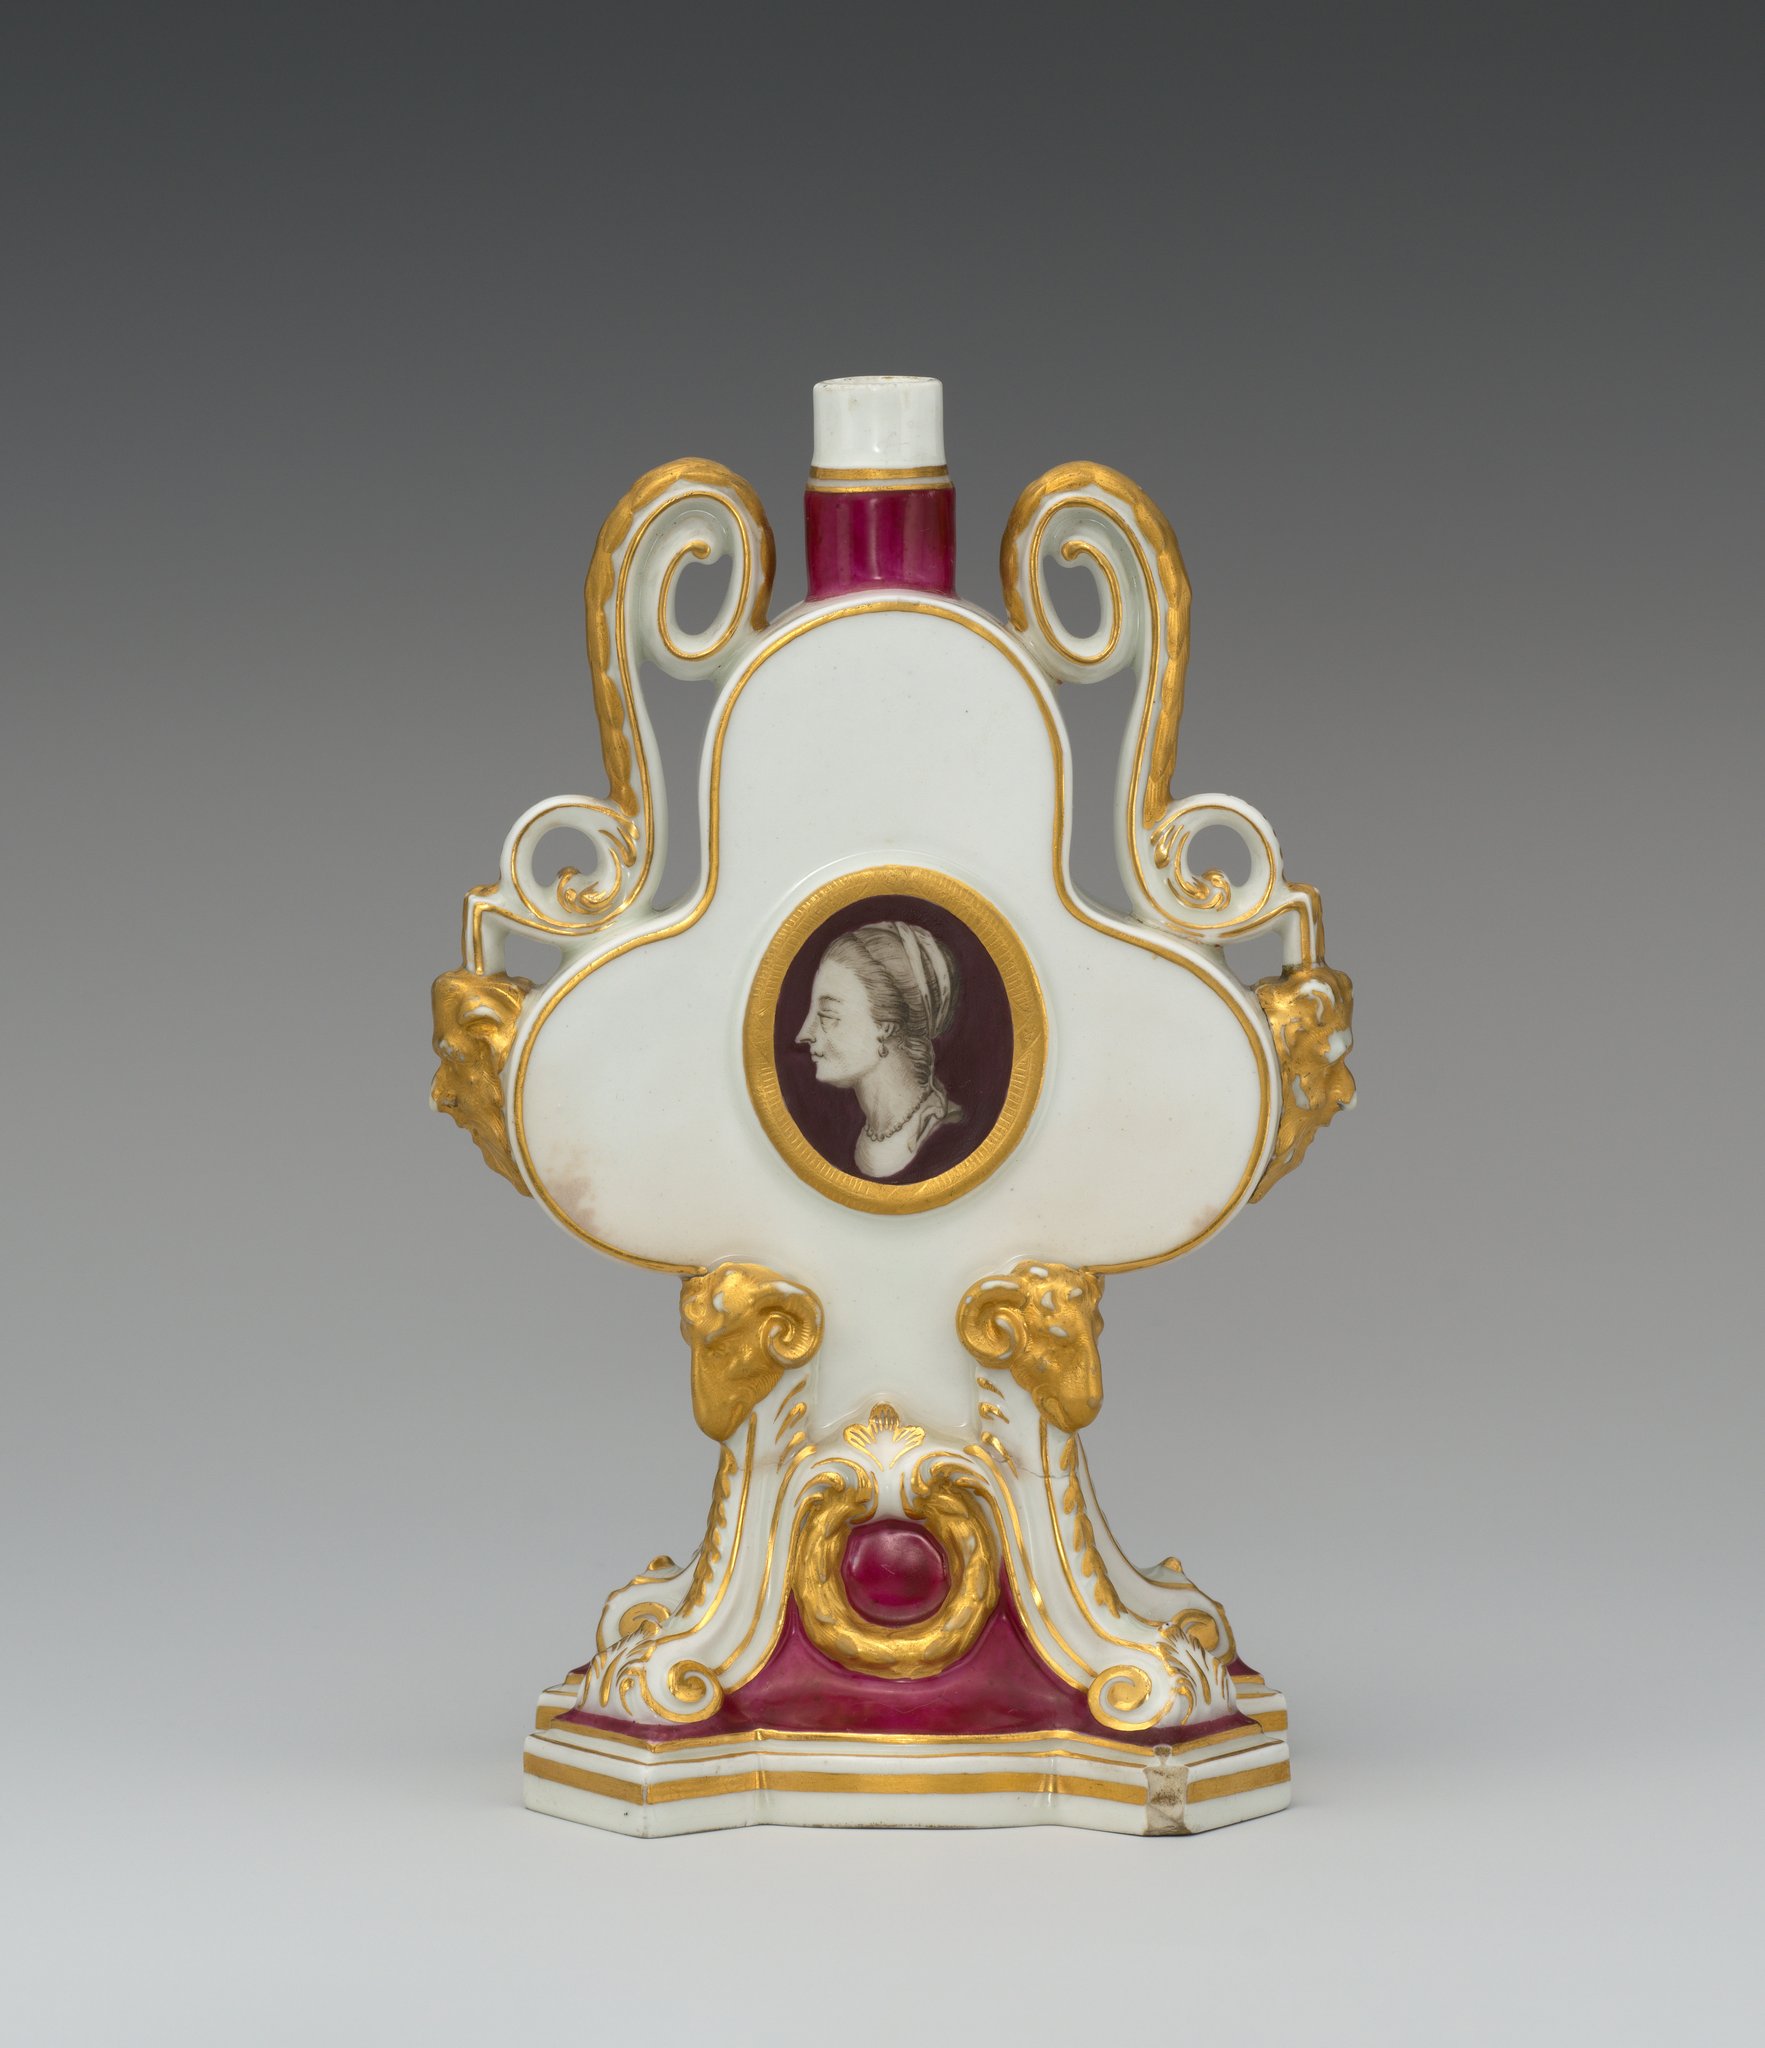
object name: toilet bottle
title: Toilet bottle (one of a pair)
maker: chelsea porcelain manufactory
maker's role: factory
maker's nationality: british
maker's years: 1744-1784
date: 1760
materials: soft paste porcelain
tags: women